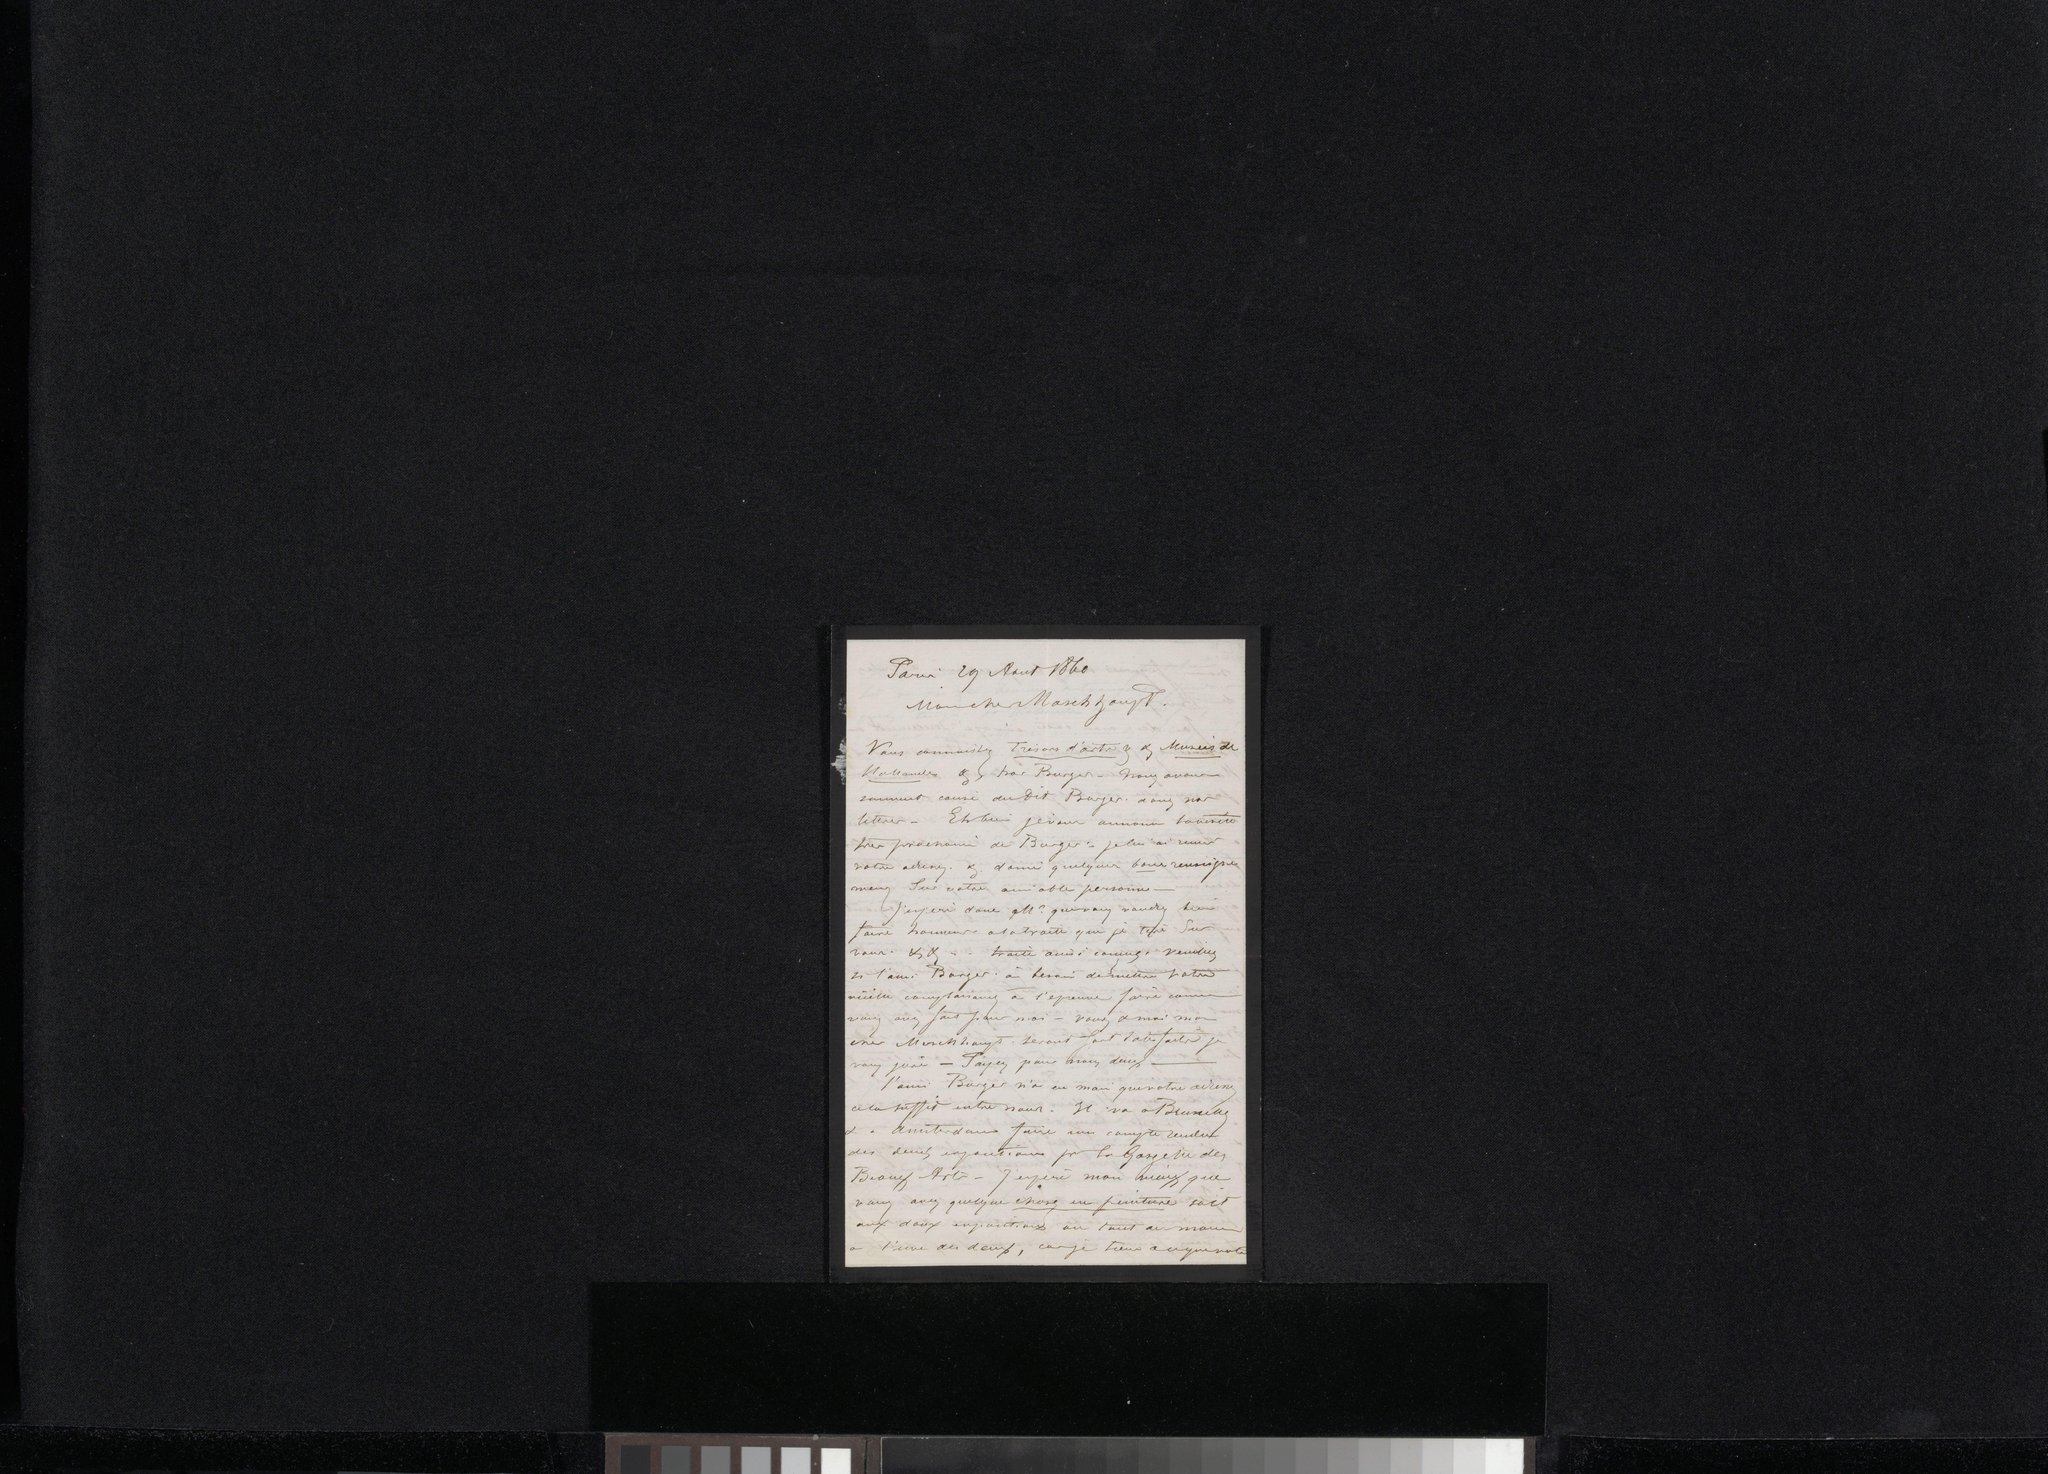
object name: letter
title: Brief aan Jan Hendrik Maschaupt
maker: adolphe mouilleron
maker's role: draughtsman, print maker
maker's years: 1820-1881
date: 1860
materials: ink, paper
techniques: pen, writing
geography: paris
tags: théophile thoré-bürger, painter, jan hendrik maschaupt, family life, painting (including book-illumination, miniature-painting), exhibition ~ art, diseases, brussels, amsterdam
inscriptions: collector's mark: ‘RPK’